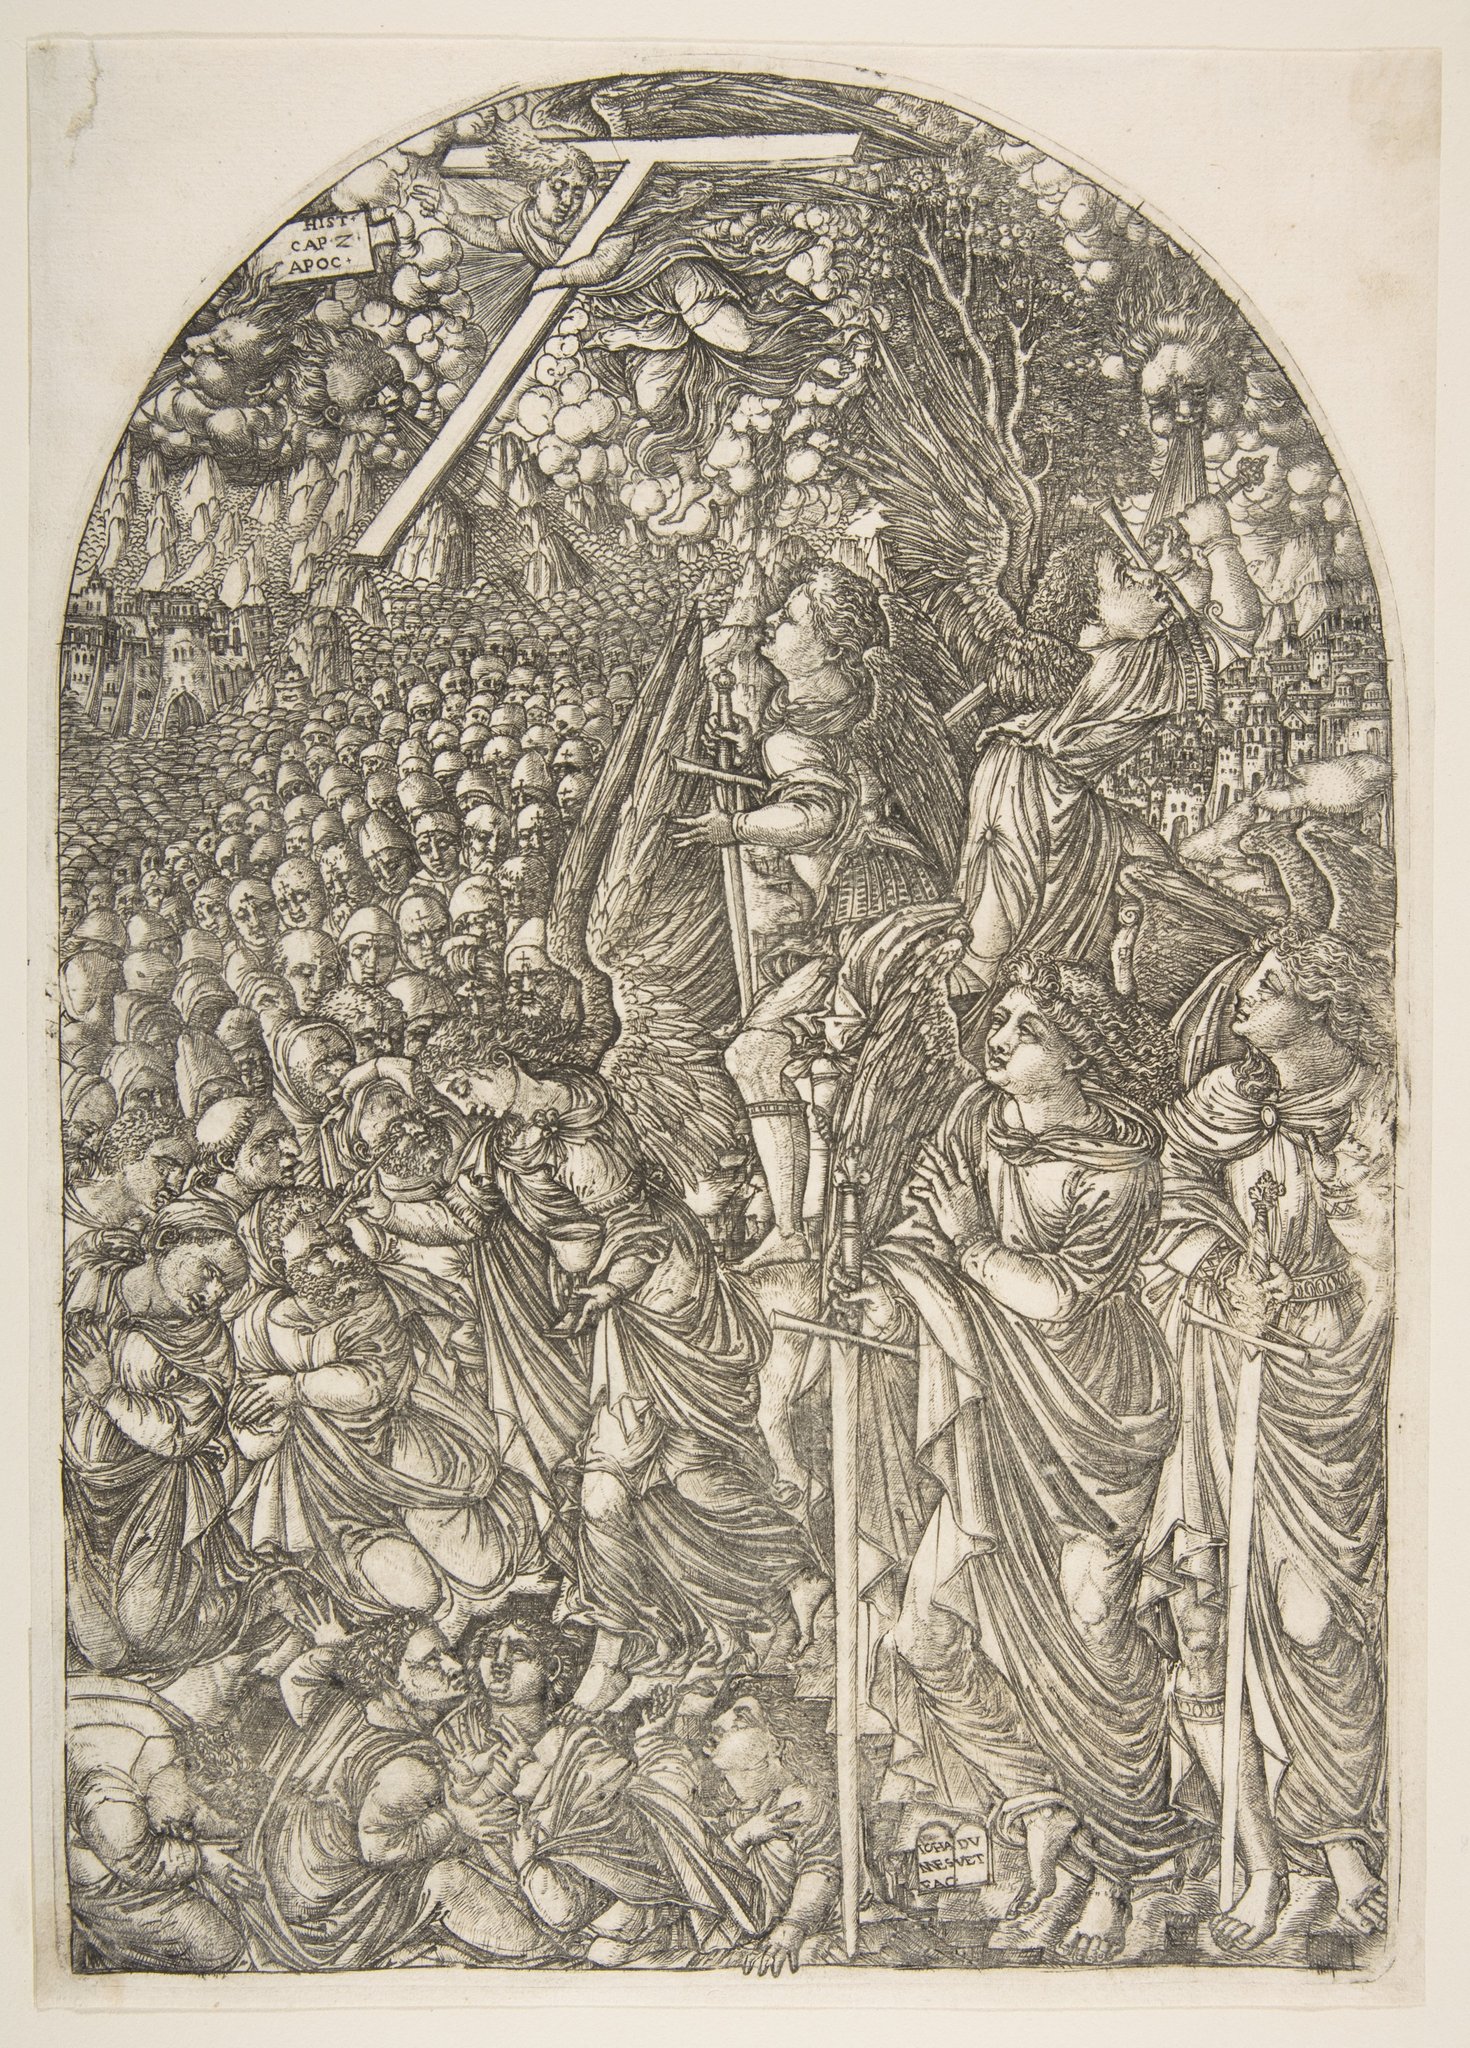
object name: print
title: Four Angels holding back the Winds, from the Apocalypse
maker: jean duvet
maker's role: artist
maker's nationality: french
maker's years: 1485-1561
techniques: engraving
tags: men,angels,apocalypse